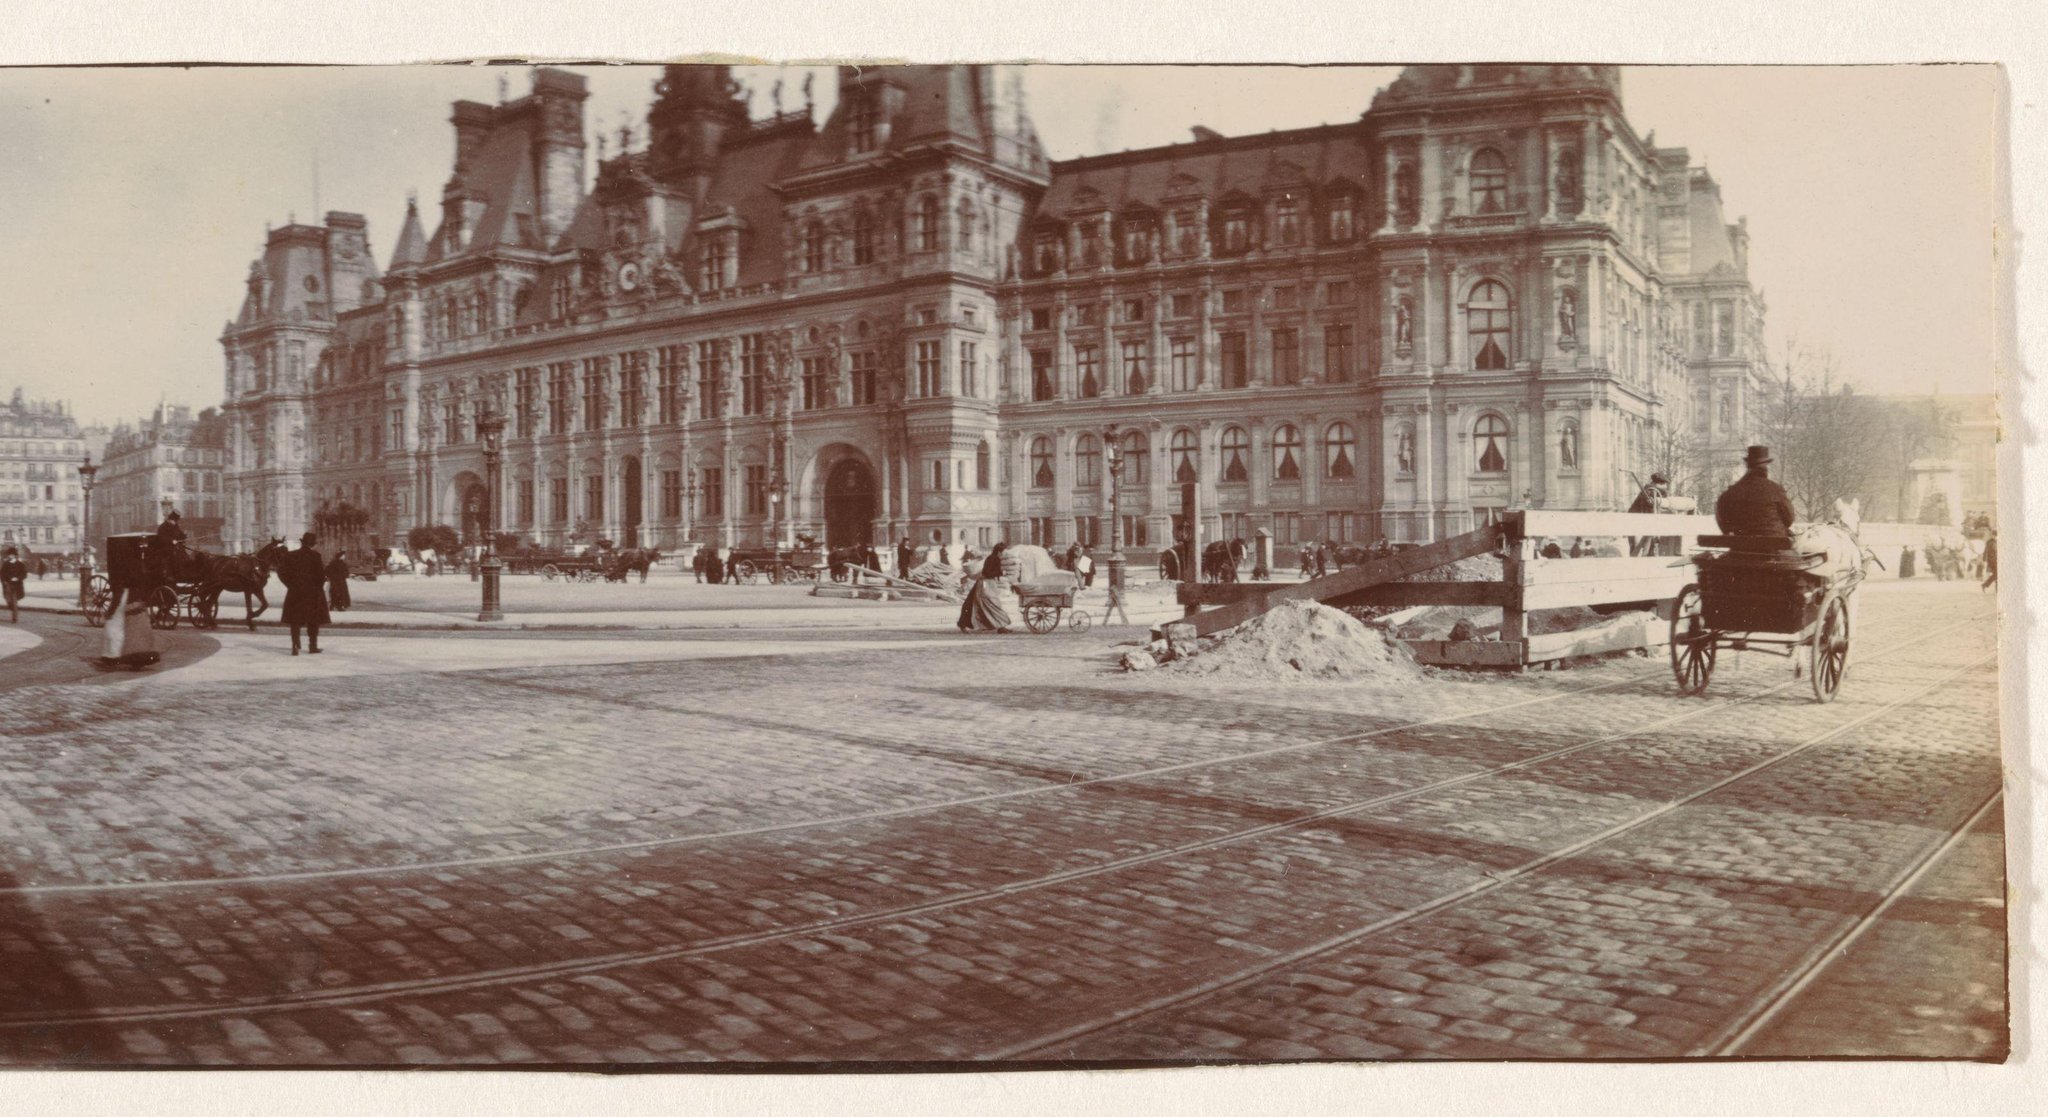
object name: panoramic photograph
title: Panorama van Parijs met Hotel de Ville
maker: Anonymous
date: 1900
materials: paper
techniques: gelatin silver print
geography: paris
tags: city-view in general; 'veduta'